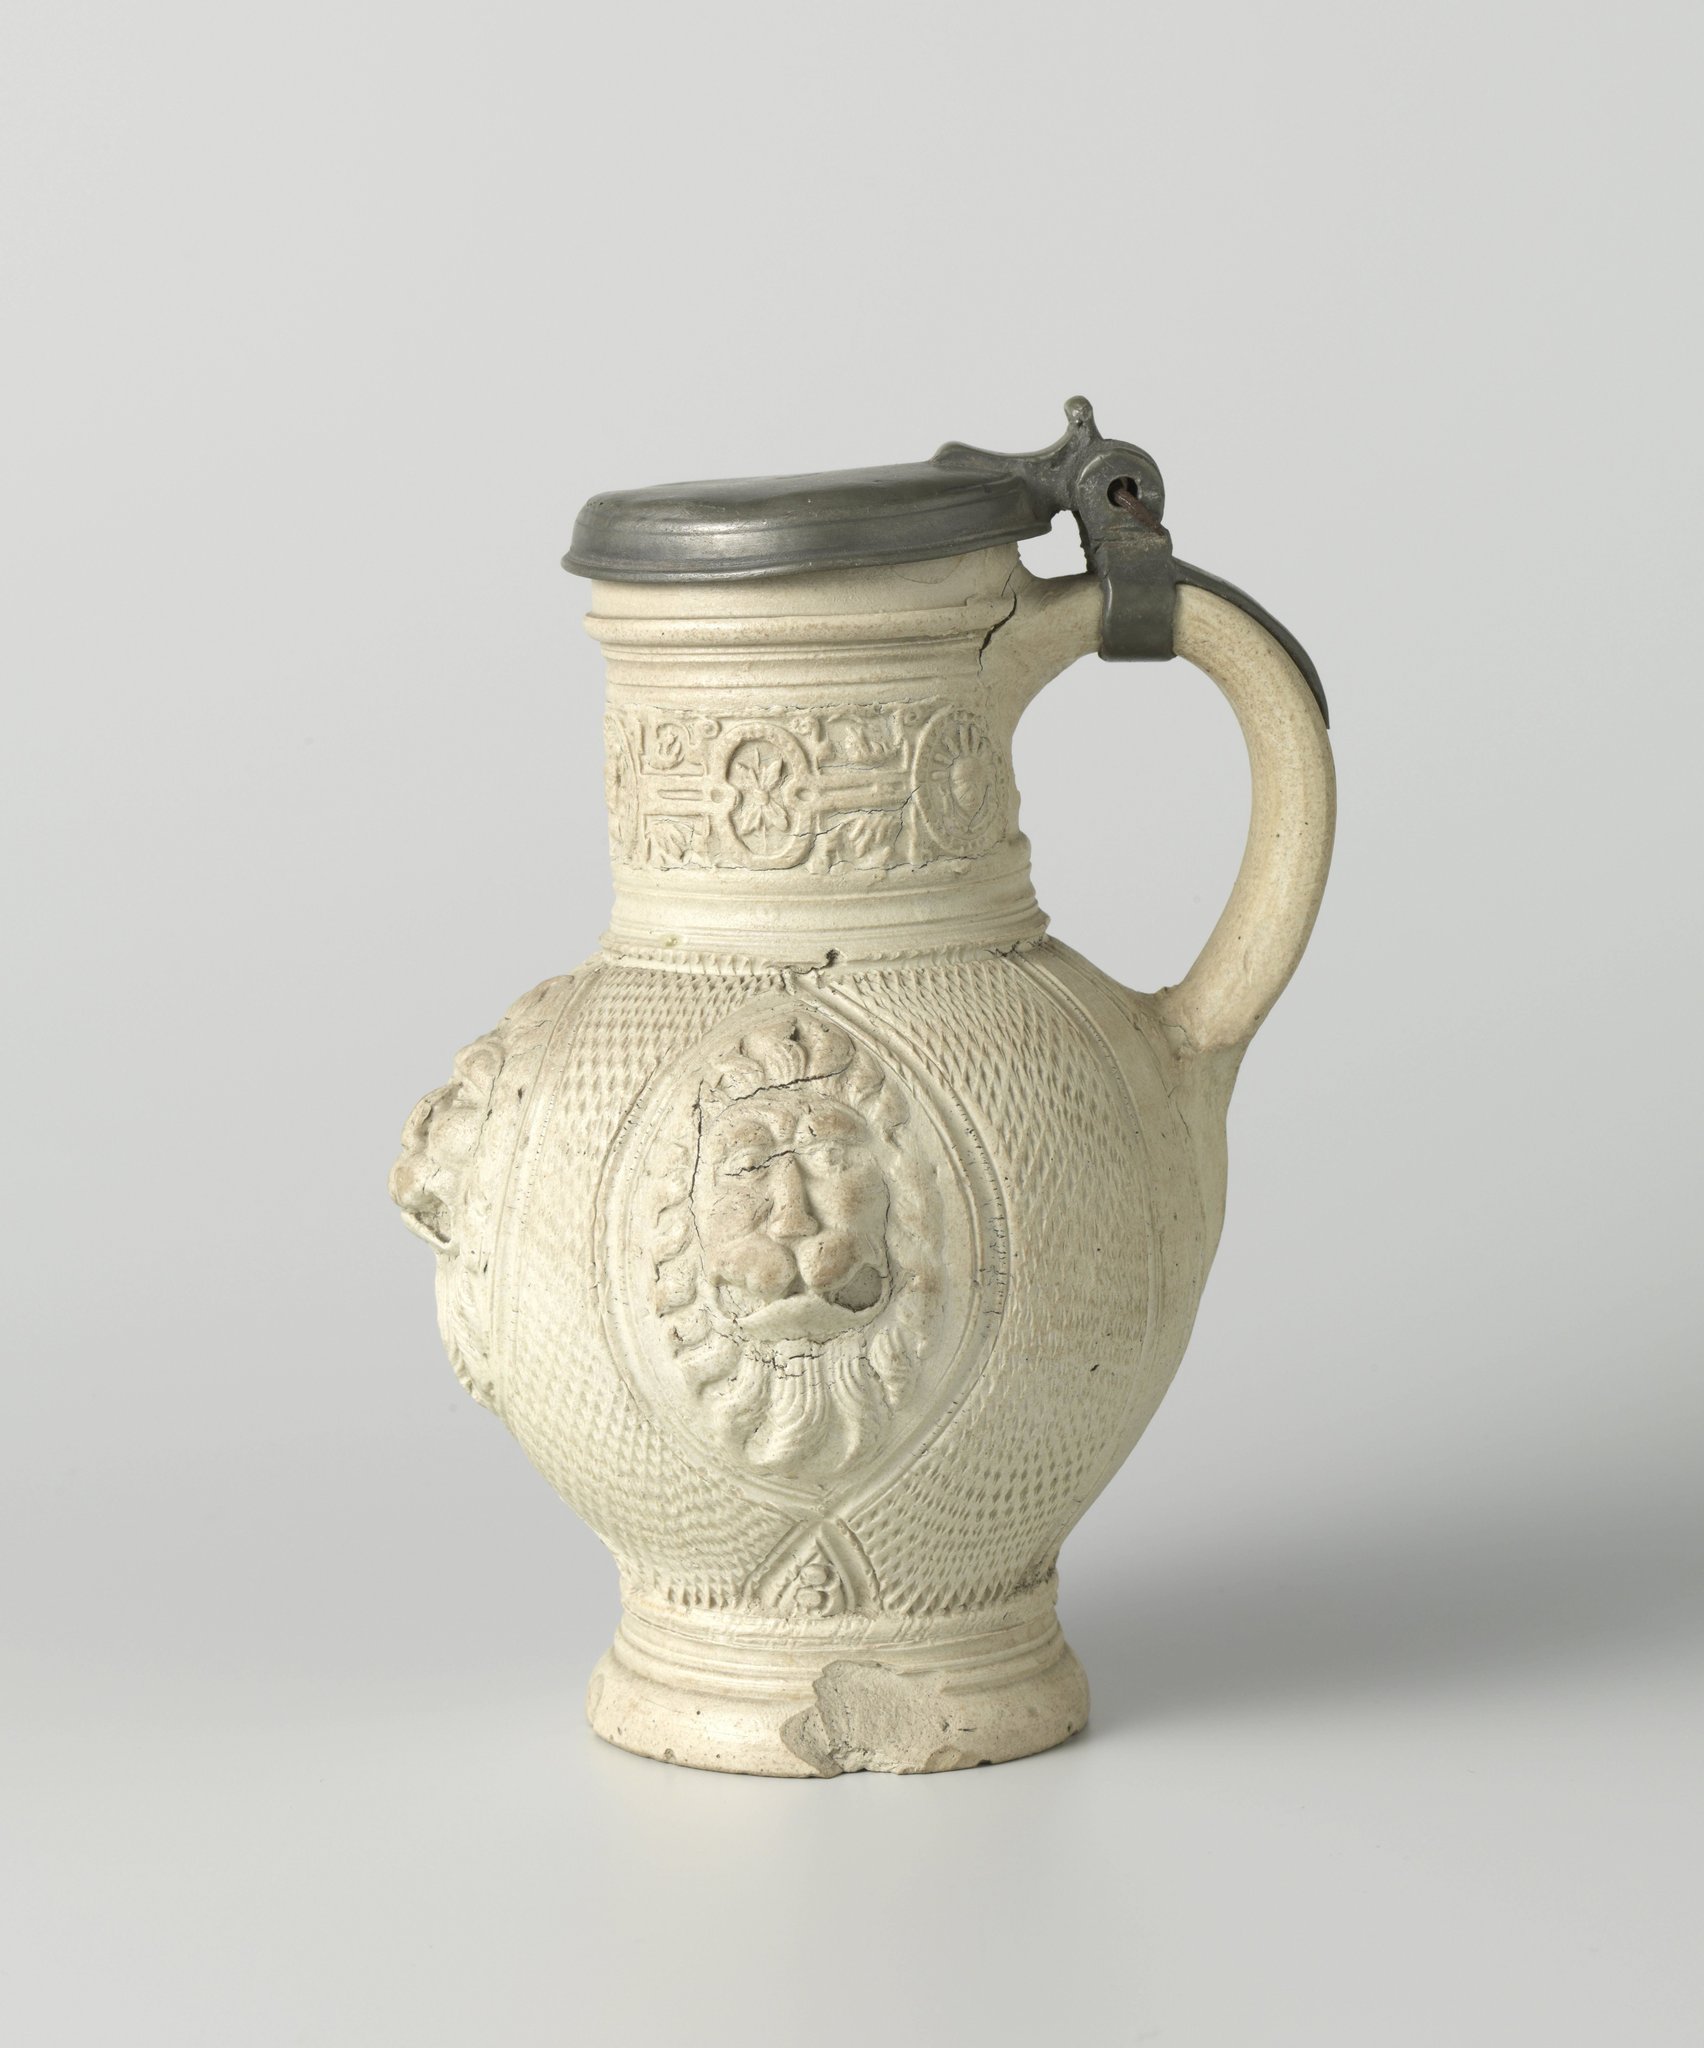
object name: jug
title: Jug with three lion heads and masks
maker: Anonymous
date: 1580-1610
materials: glaze, stoneware, tin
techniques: printing, firing, forming, relief, turning, vitrification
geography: siegburg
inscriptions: mark: ‘N.I.’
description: Kruik van steengoed op hoge voet met bolvormig lichaam en wijde nek. Het C-vormige oor is bevestigd aan den nek en de schouder. Profielen op de nek en de voet. De buik is bedekt met kerfsnede met daarin uitgespaard drie gedrukte en opgelegde medaillons met een leeuwenkop in reliëf. Daaronder een klein vak met twee gestempelde rozetten. Op de nek een band in reliëf met aaneengeschakelde medaillons met maskers of een bloem, omgeven door bladranken. Bevestigd aan het oor een tinnen montuur met deksel. Aan de binnenzijde een merk met de letters 'N.I'. Siegburg.